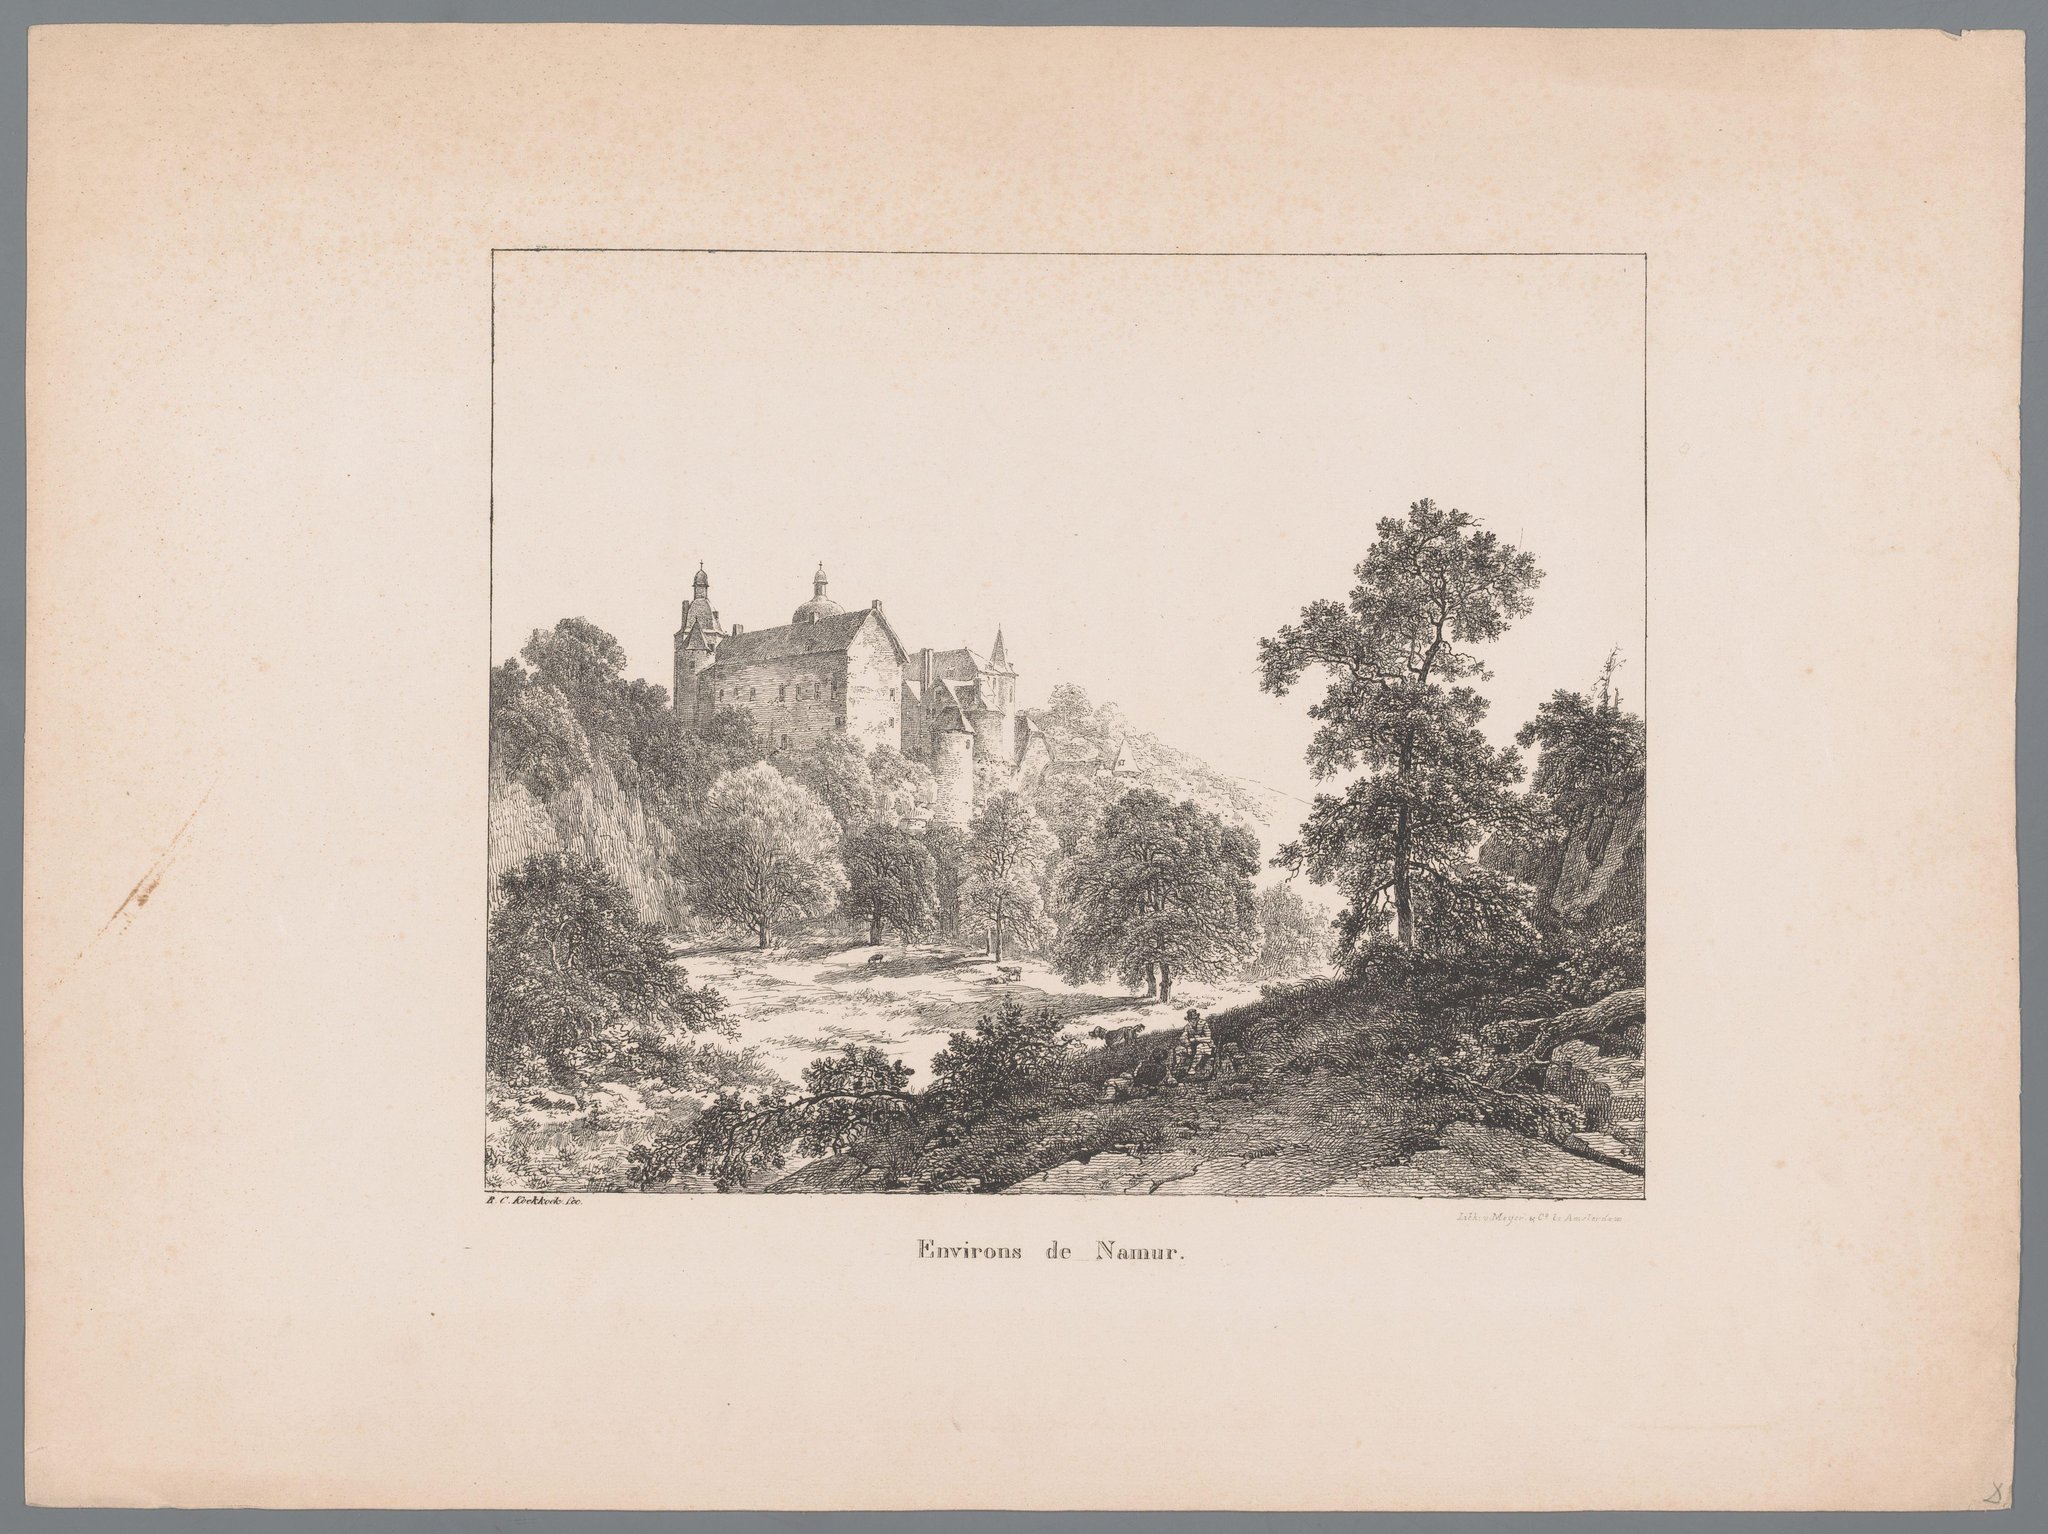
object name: print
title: Gezicht op een kasteel in een bosrijk landschap bij Namen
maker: barend cornelis koekkoek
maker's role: draughtsman, painter, print maker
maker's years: 1803-1862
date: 1813-1862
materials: paper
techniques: lithograph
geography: amsterdam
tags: landscape with tower or castle